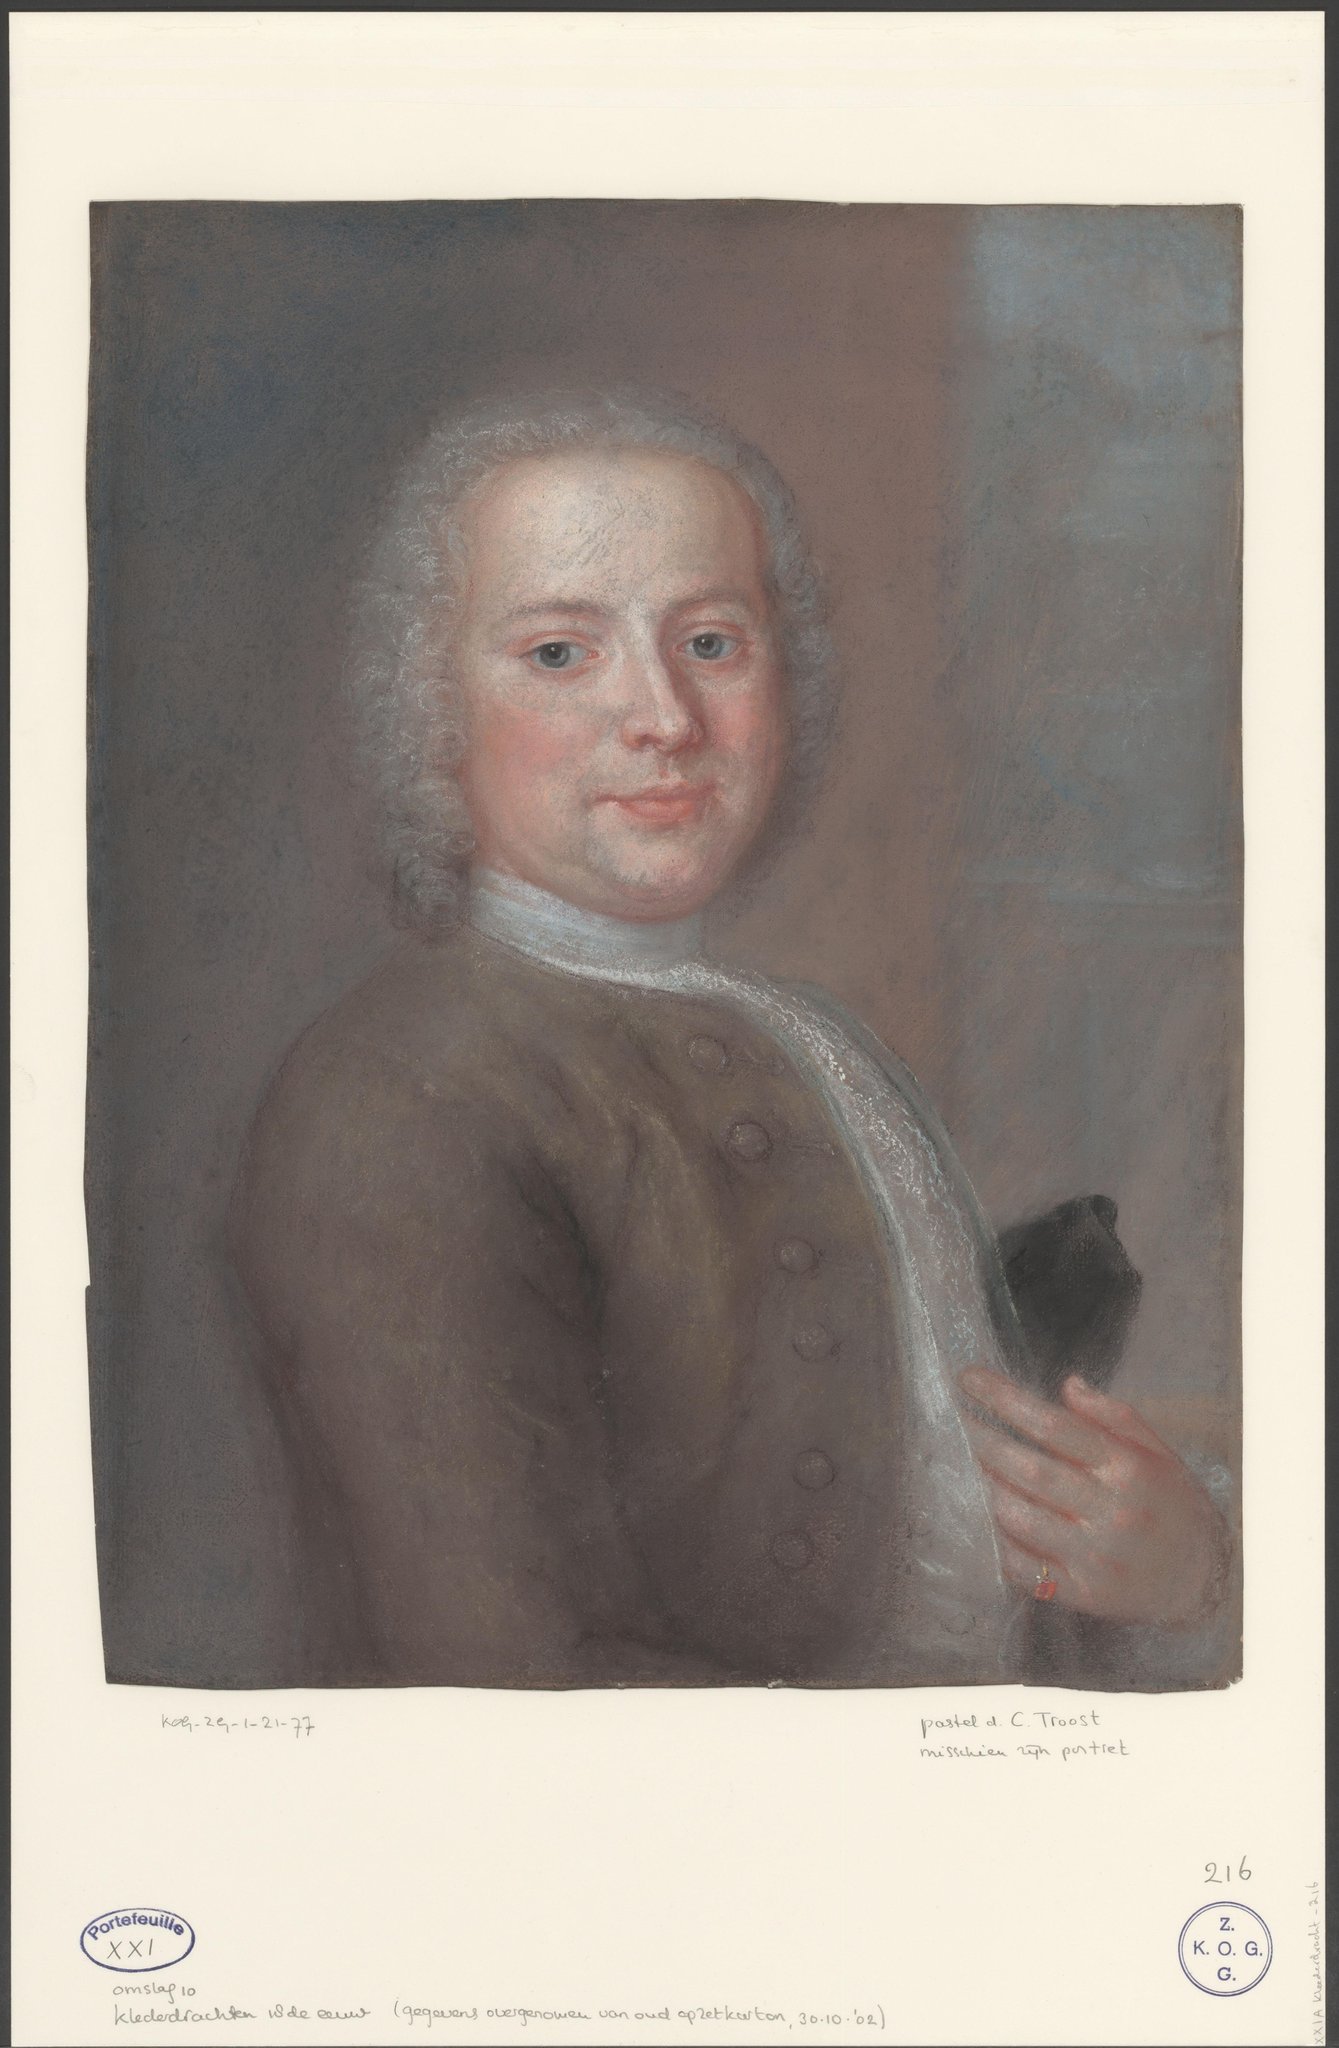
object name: drawing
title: Portret van een onbekende man, mogelijk een zelfportret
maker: cornelis troost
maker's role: draughtsman, painter, print maker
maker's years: 1696-1750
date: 1712-1750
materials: paper, pastel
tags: amsterdam, painter, print maker, draughtsman, cornelis troost, head-gear: tricorn, coat, historical persons, wig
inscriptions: collector's mark: Lugt 1641, stamp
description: Onderwerpsrubrieken binnen de Atlas Zeden en Gewoonten: Zeden en Gewoonten in Engeren Zin, De Kleeding, Kleederdrachten (tijdvakken), De 18de eeuw (de pruikentijd). Mannen en vrouwen.